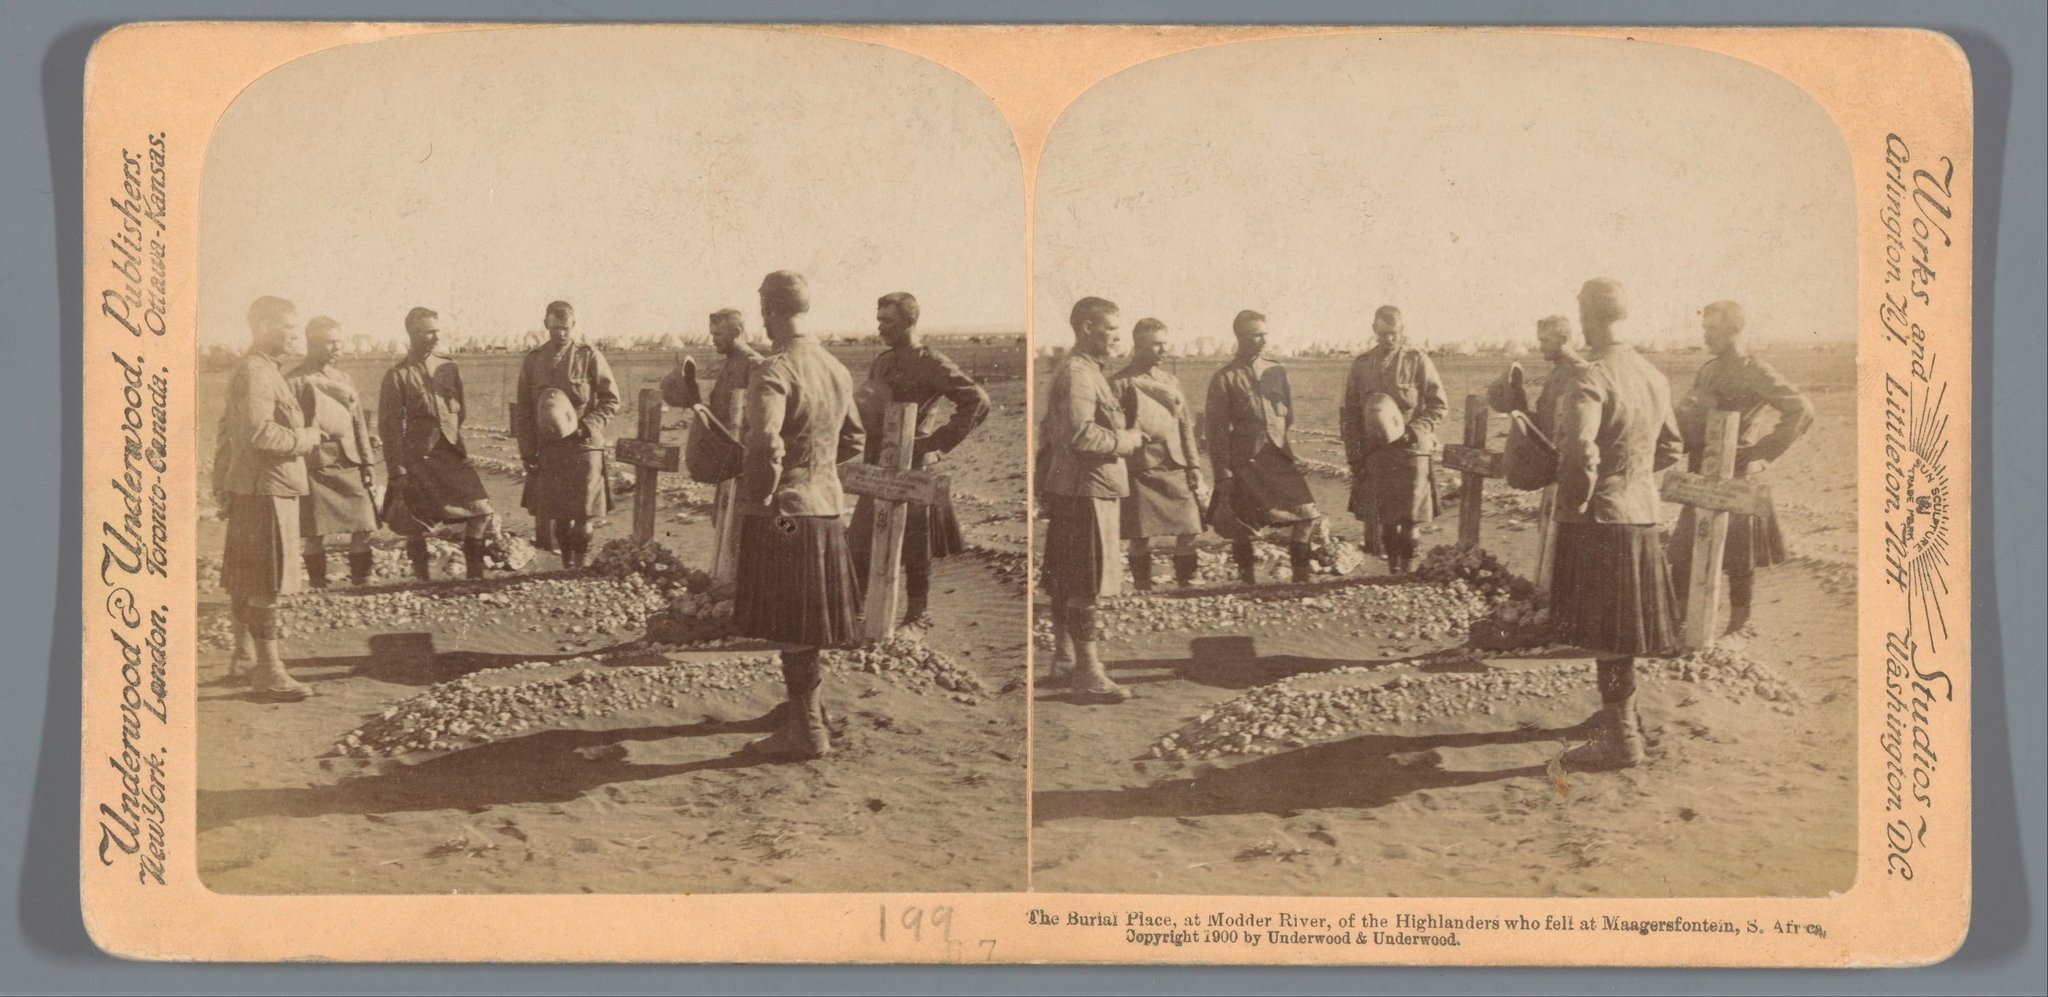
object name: stereograph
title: The Burial Place, at Modder River, of the Highlanders who fell at Maagersfontein, S. Africa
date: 1900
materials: cardboard, photographic support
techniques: albumen print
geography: south africa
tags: grave, tomb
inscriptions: number: ‘199’, name: ‘Works and Studios Sun Sculpture trade mark Arlington N.J. Littleton N.H. Washington D.C.’